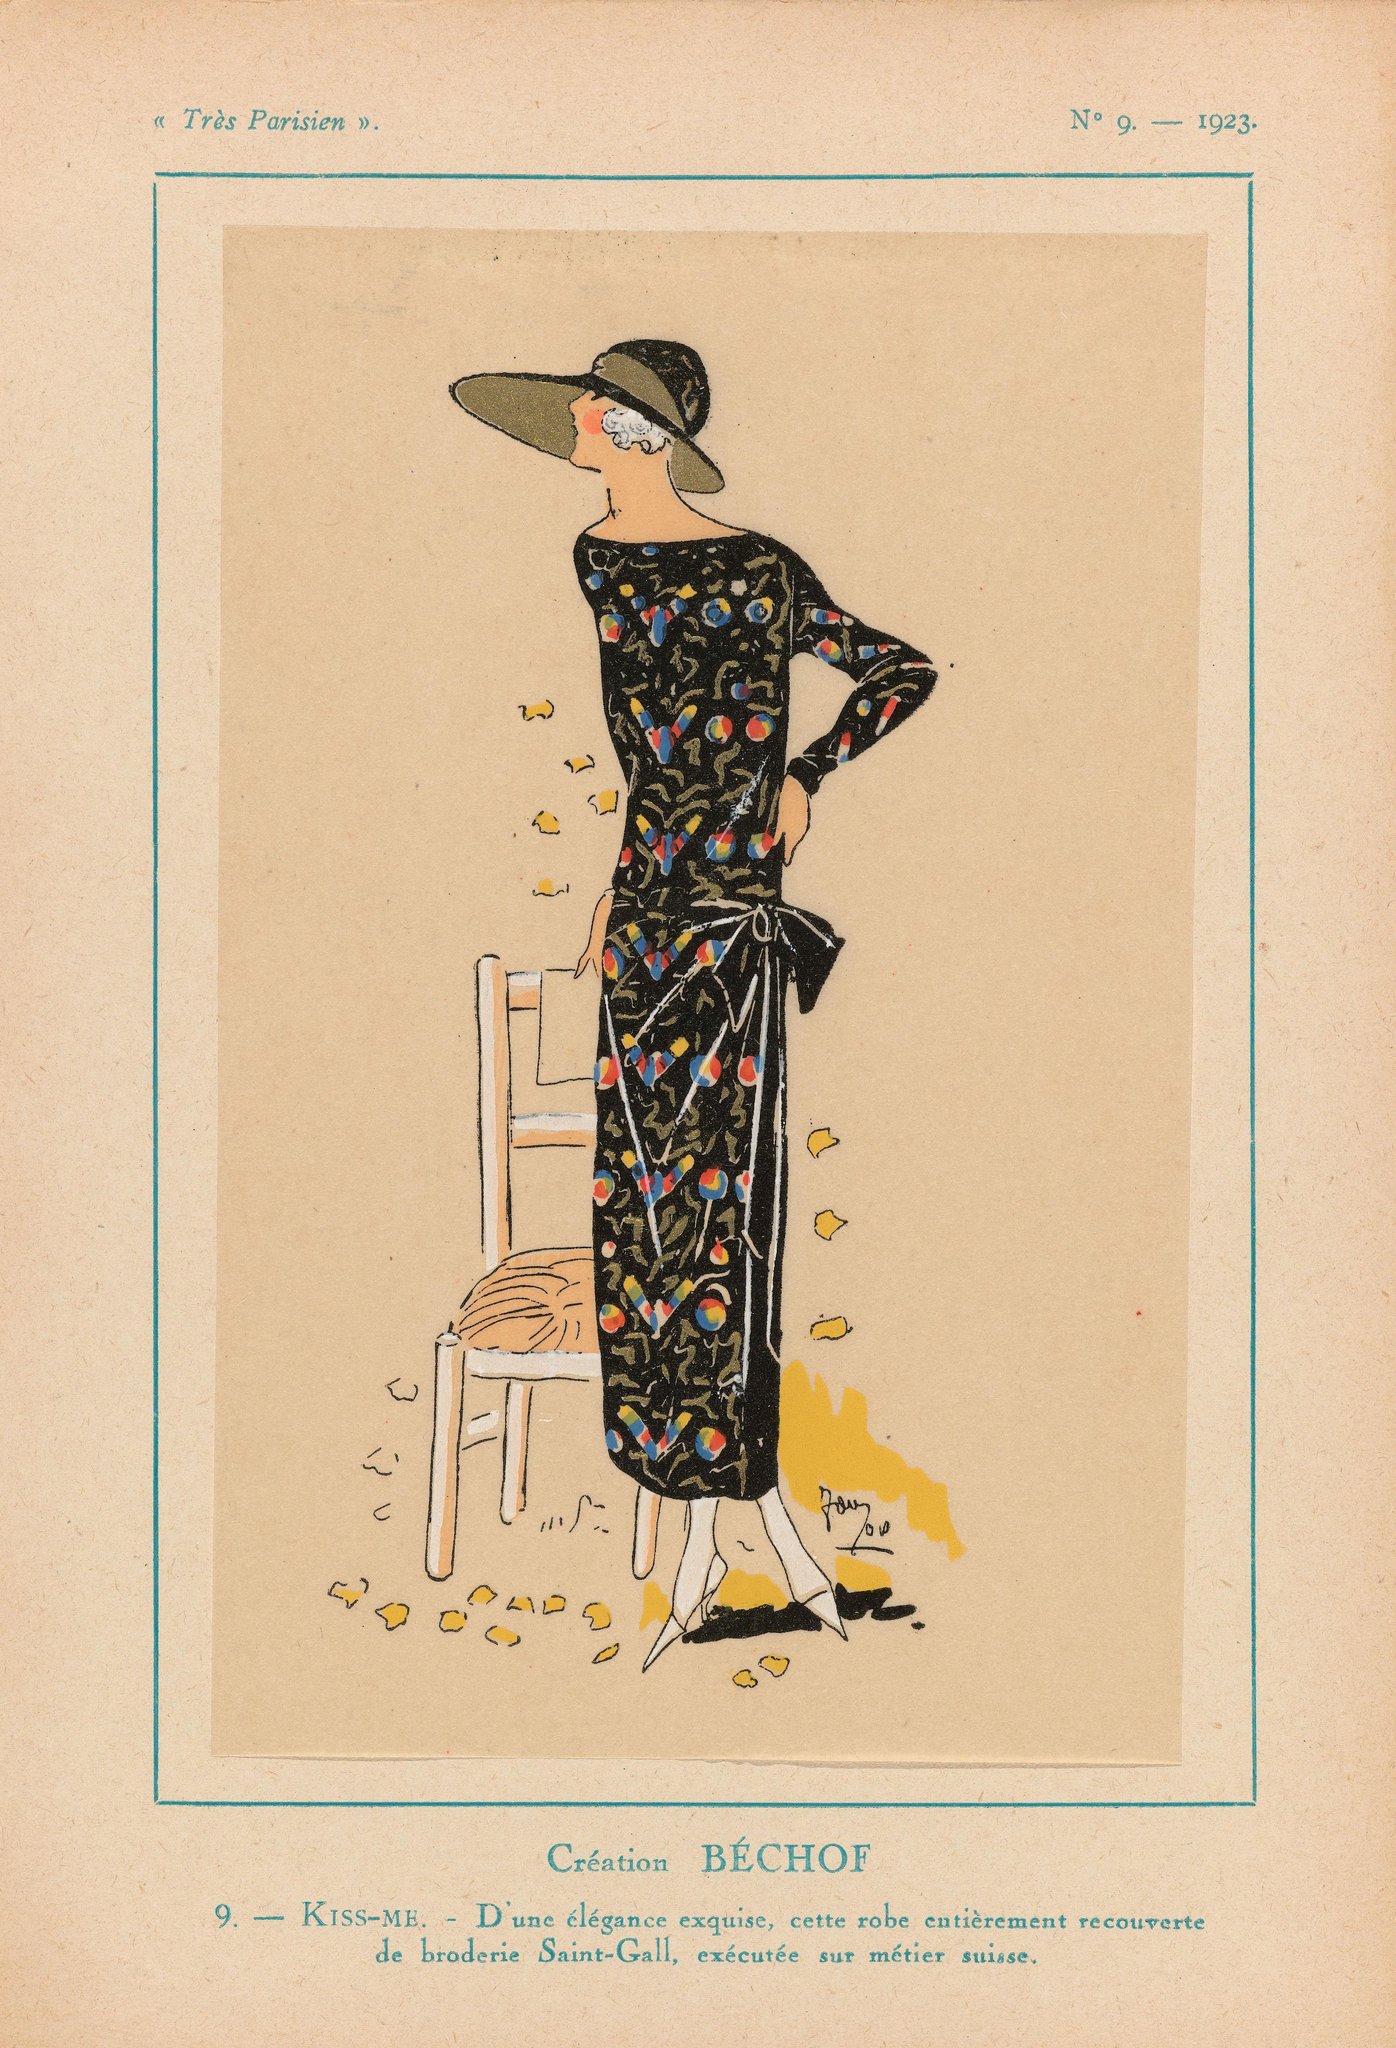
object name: fashion print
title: Très Parisien, 1923, No 9: 9 - KISS-ME. - D'une élégance exquise,...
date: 1923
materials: paper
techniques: hand coloring, letterpress printing, lithography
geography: paris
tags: embroidery (ornamentation) (+ women's clothes), fashion plates, head-gear: hat (+ women's clothes), dress, gown (+ women's clothes)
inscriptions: title: ‘Très Parisien / No 9. - 1923’, caption: ‘Création BÉCHOF / 9. - KISS-ME. - D'une élégance exquise, cette robe entièrement recouverte de broderie Saint-Gall, exécutée sur métier suisse.’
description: Ontwerp van Béchof. Jurk volledig bedekt met borduurwerk Saint-Gall, uitgevoerd op de Zwitserse manier. Accessoires: hoed met brede luifel, pumps. Prent uit het modetijdschrift Très Parisien (1920-1936).